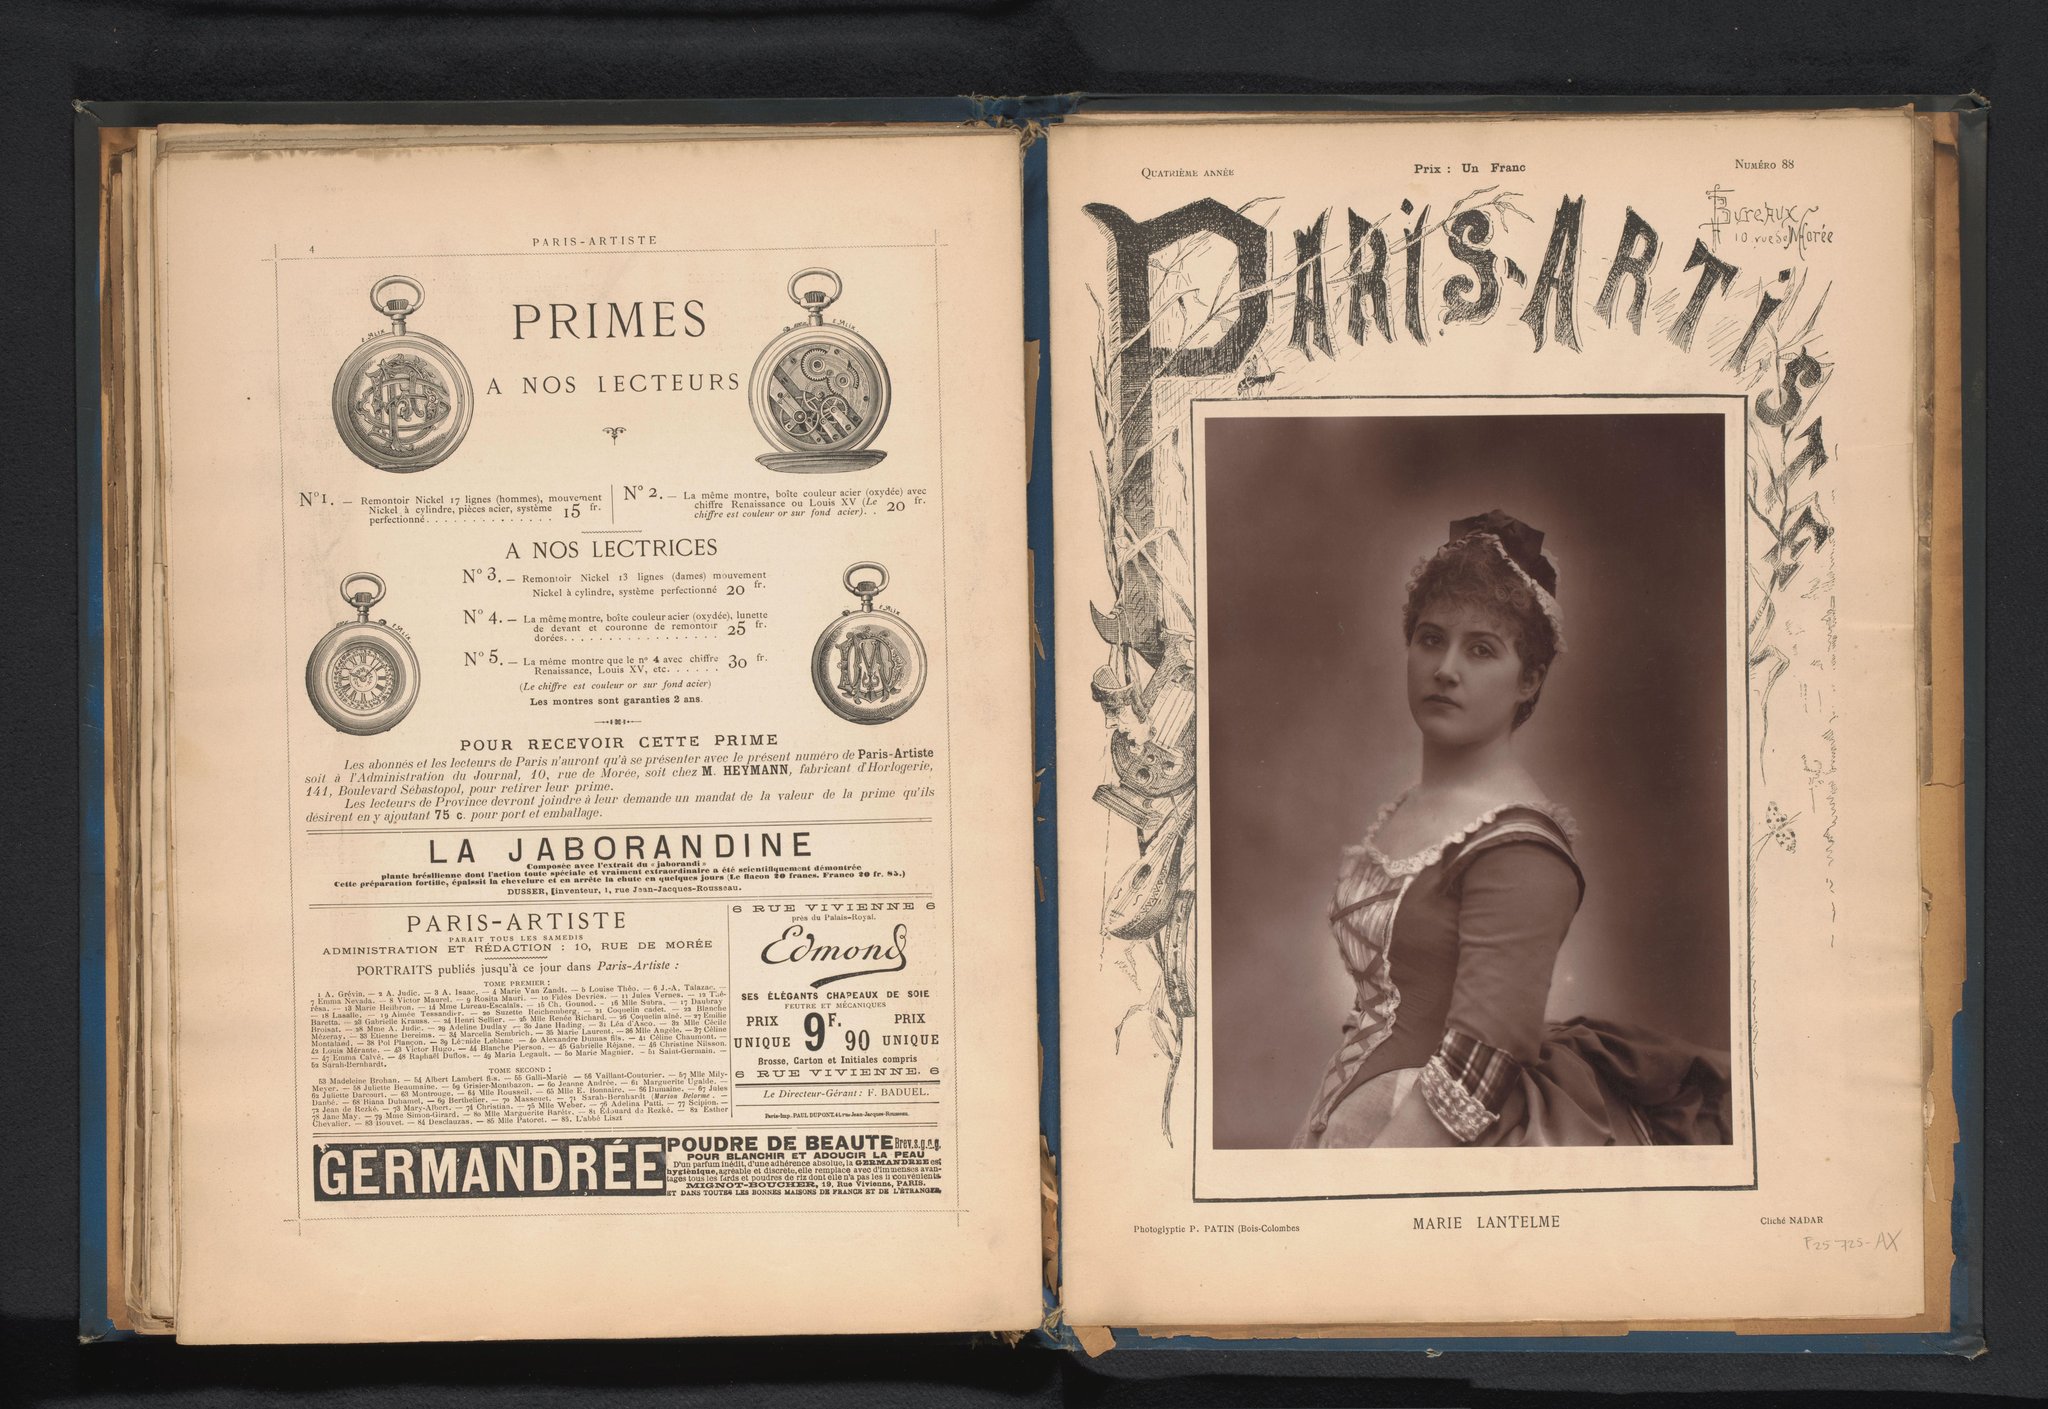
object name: page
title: Portret van Marie Lantelme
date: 1880-1886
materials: paper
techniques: woodburytype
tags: historical persons, portrait of actor, actress